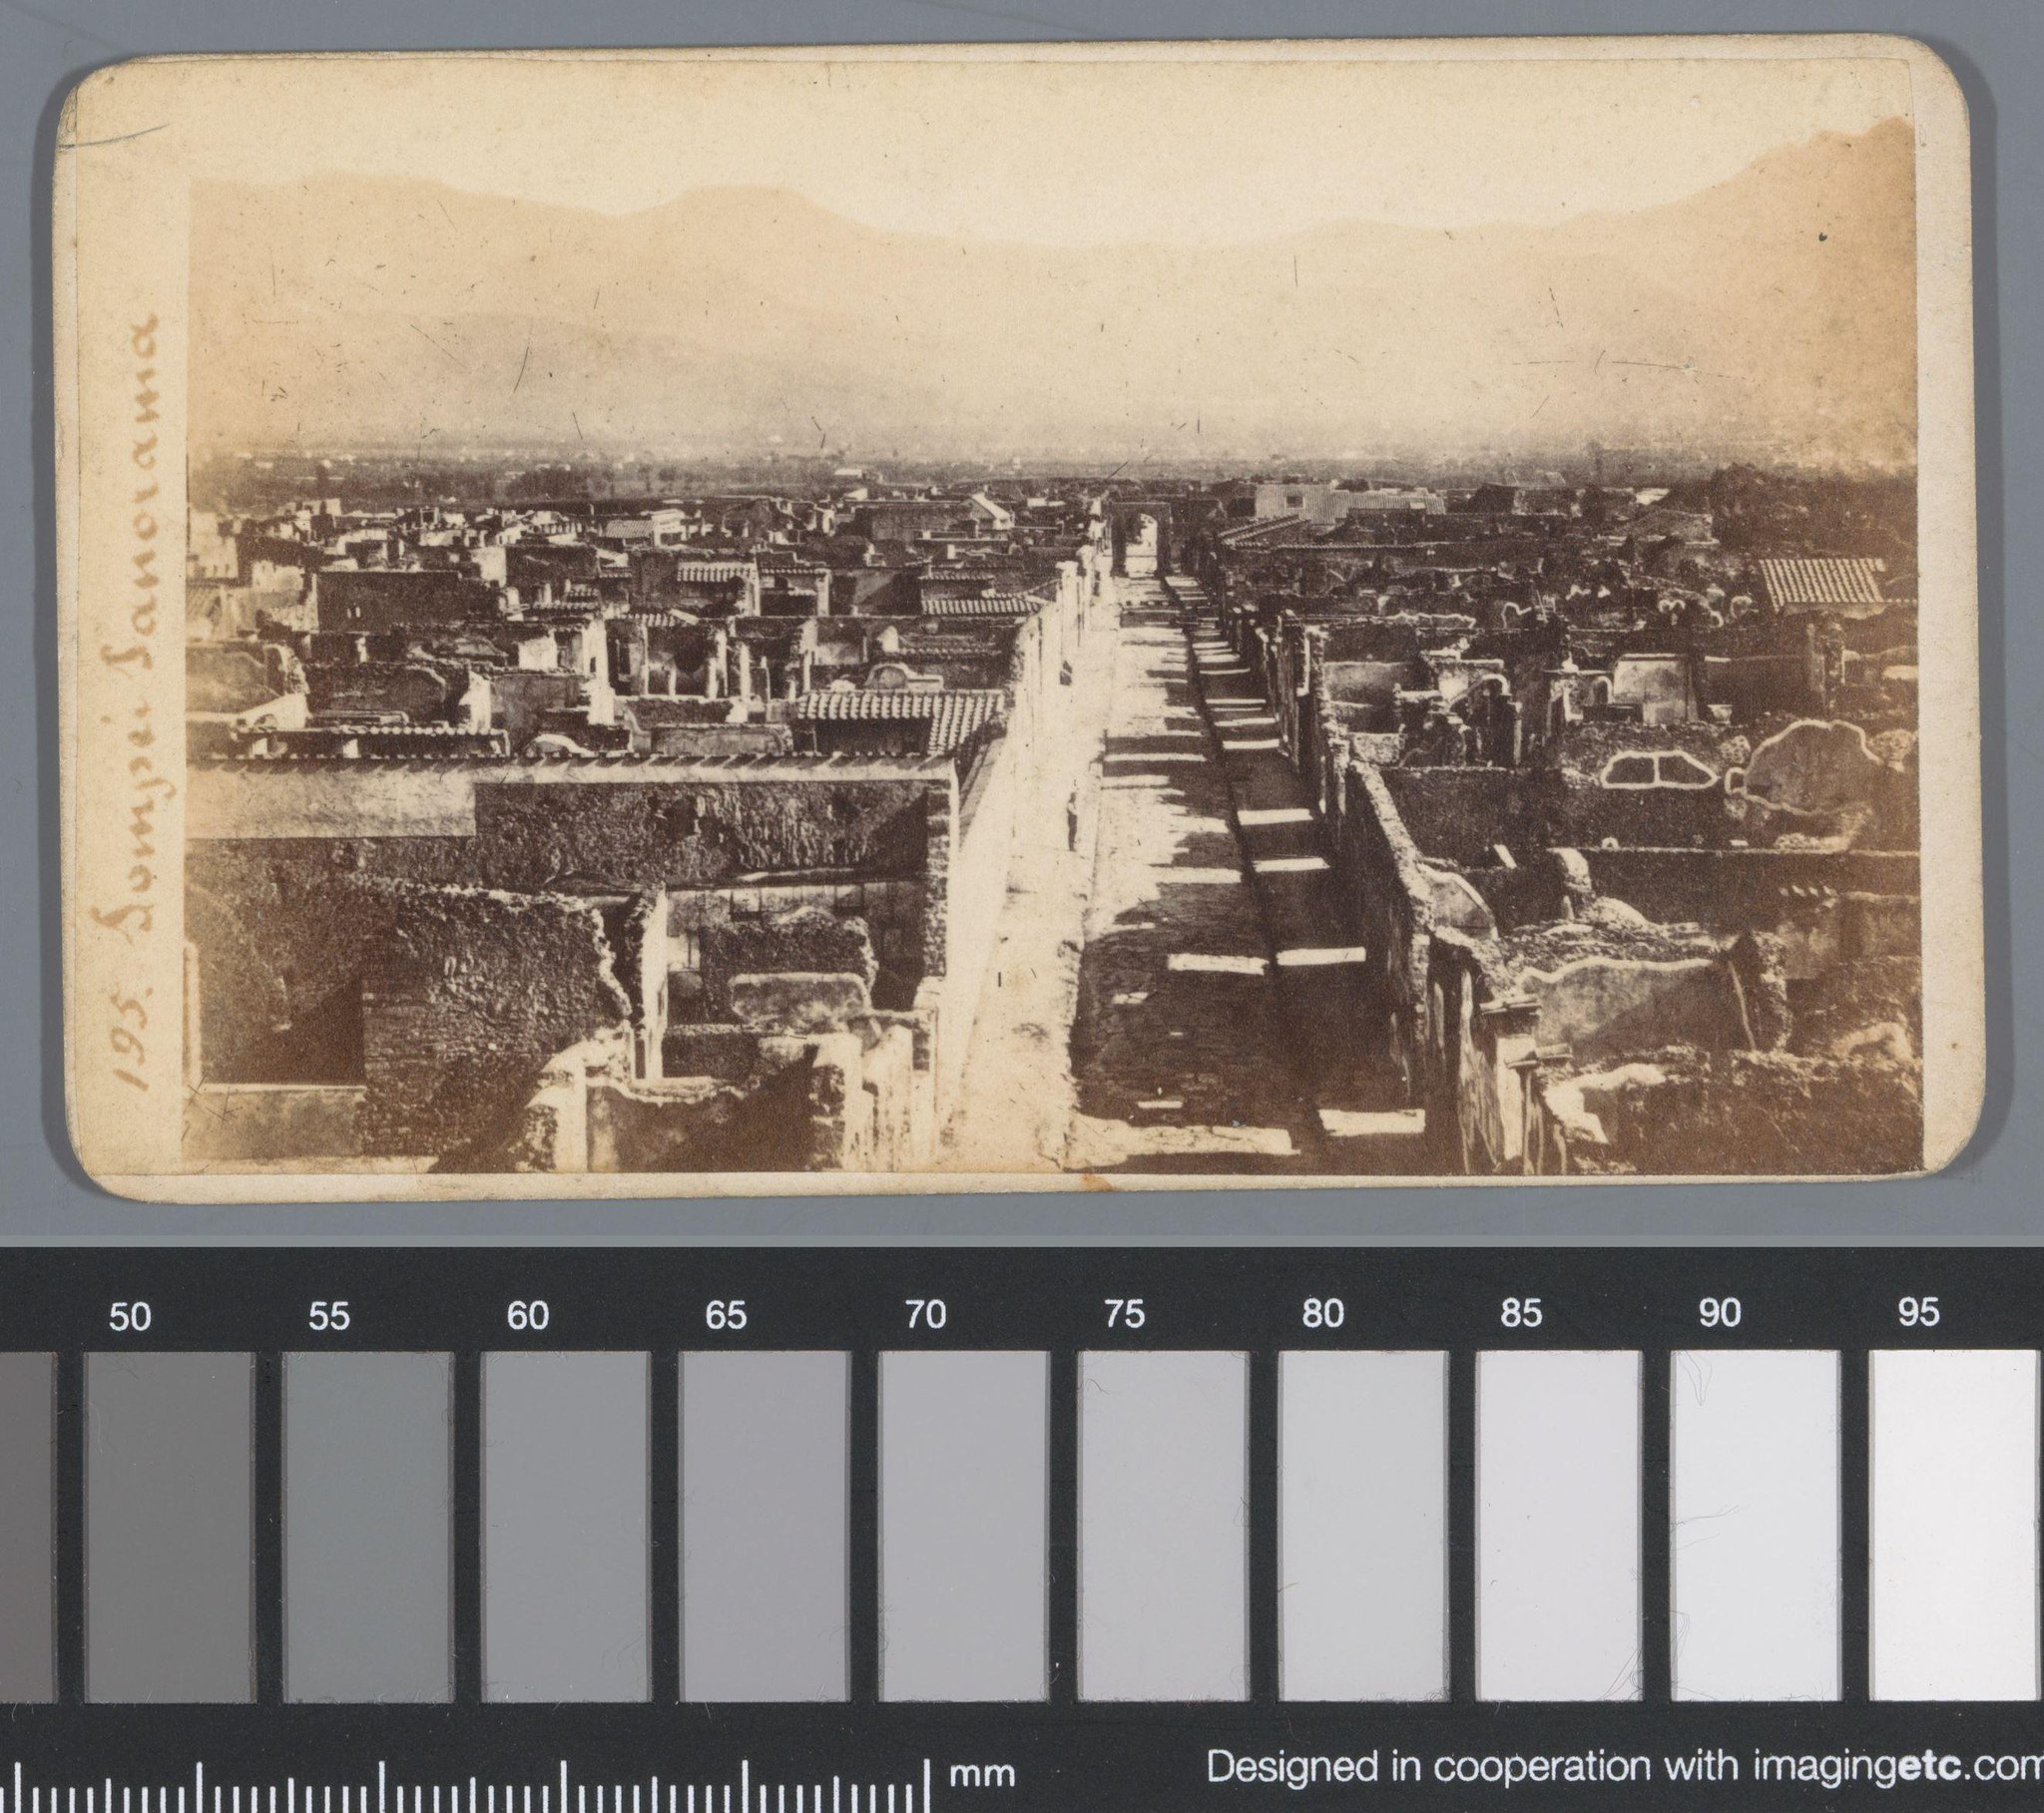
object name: photograph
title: Gezicht op een straat in Pompeï, Italië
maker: Anonymous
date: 1854-1885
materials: cardboard, paper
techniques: albumen print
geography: pompeii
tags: city-view in general; 'veduta', pompeii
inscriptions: number: ‘195.’